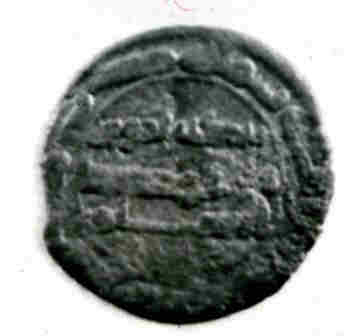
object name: coin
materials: copper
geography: iran